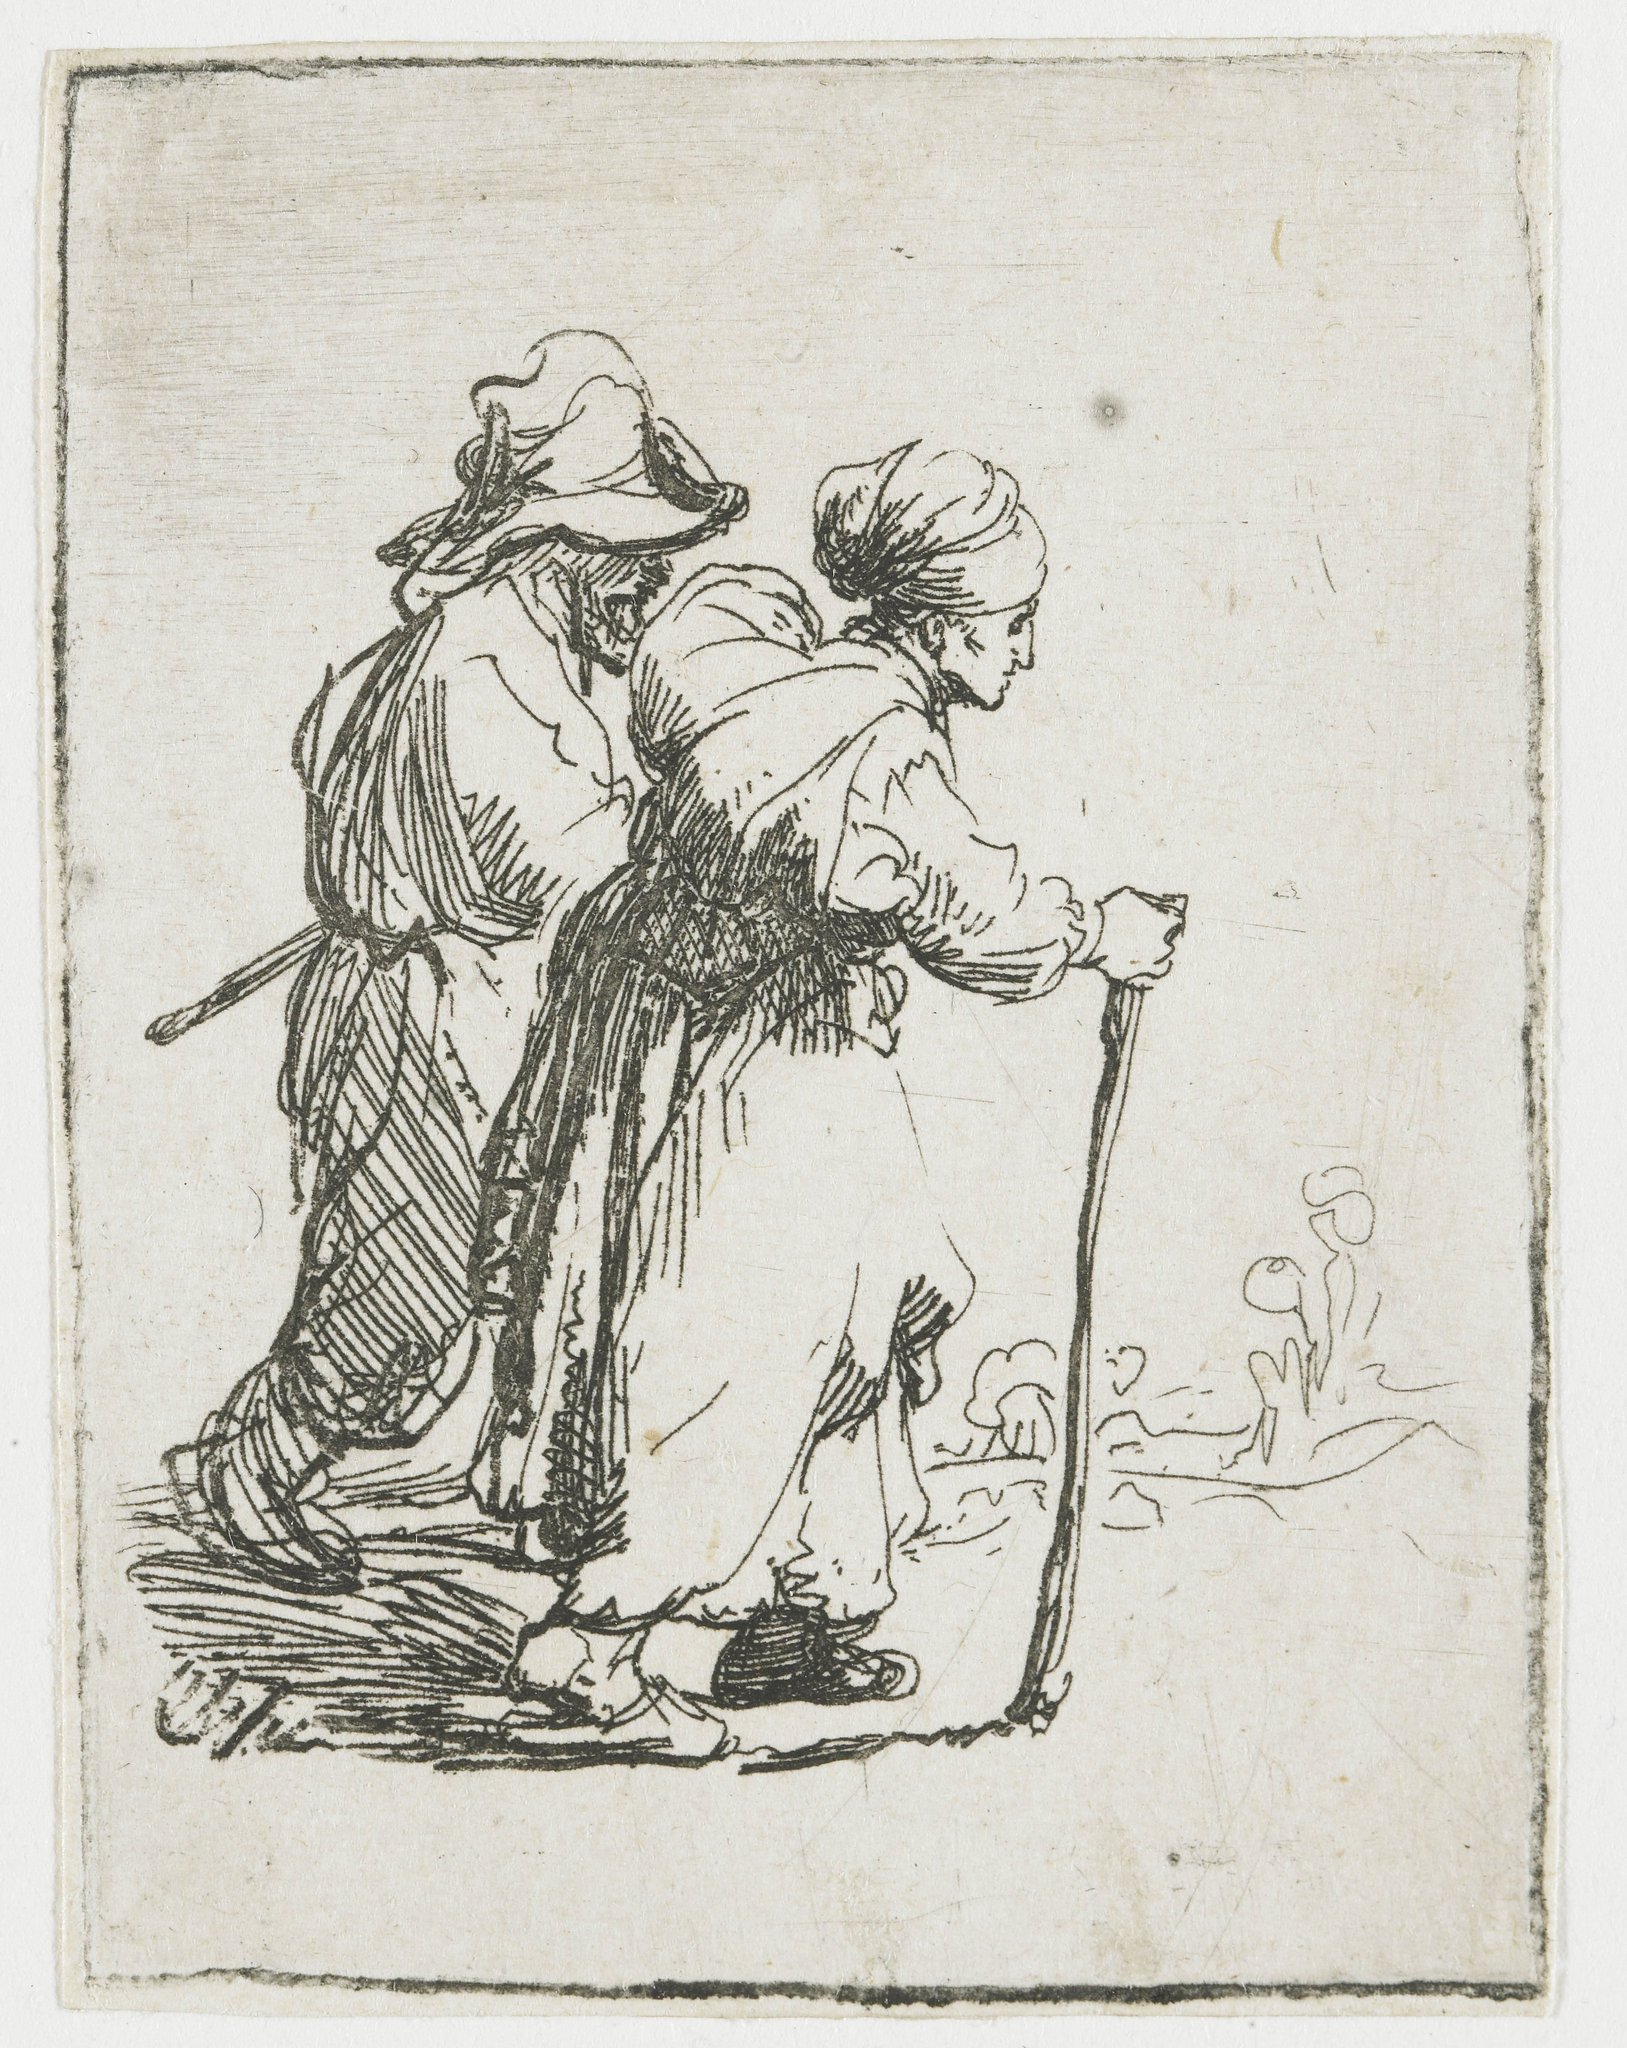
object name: print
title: Two tramps, a man and a woman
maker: rembrandt van rijn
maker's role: draughtsman, painter, print maker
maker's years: 1606-1669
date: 1634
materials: paper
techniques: etching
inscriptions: collector's mark: Lugt 240